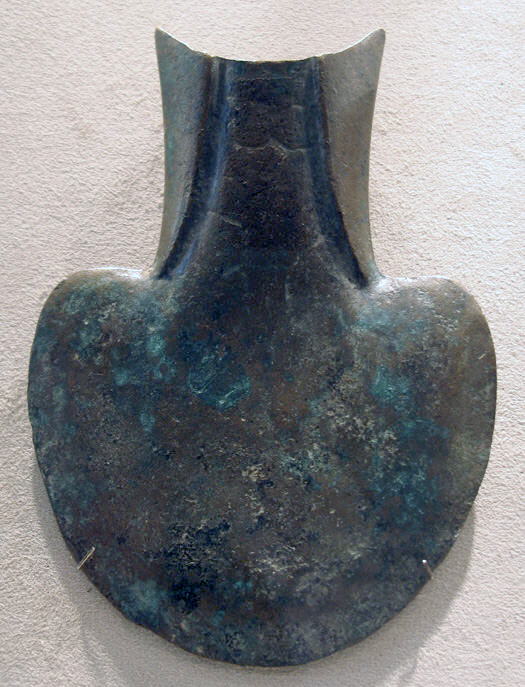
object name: ax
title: Hafted Ax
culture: indonesian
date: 500 BCE-300 CE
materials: bronze